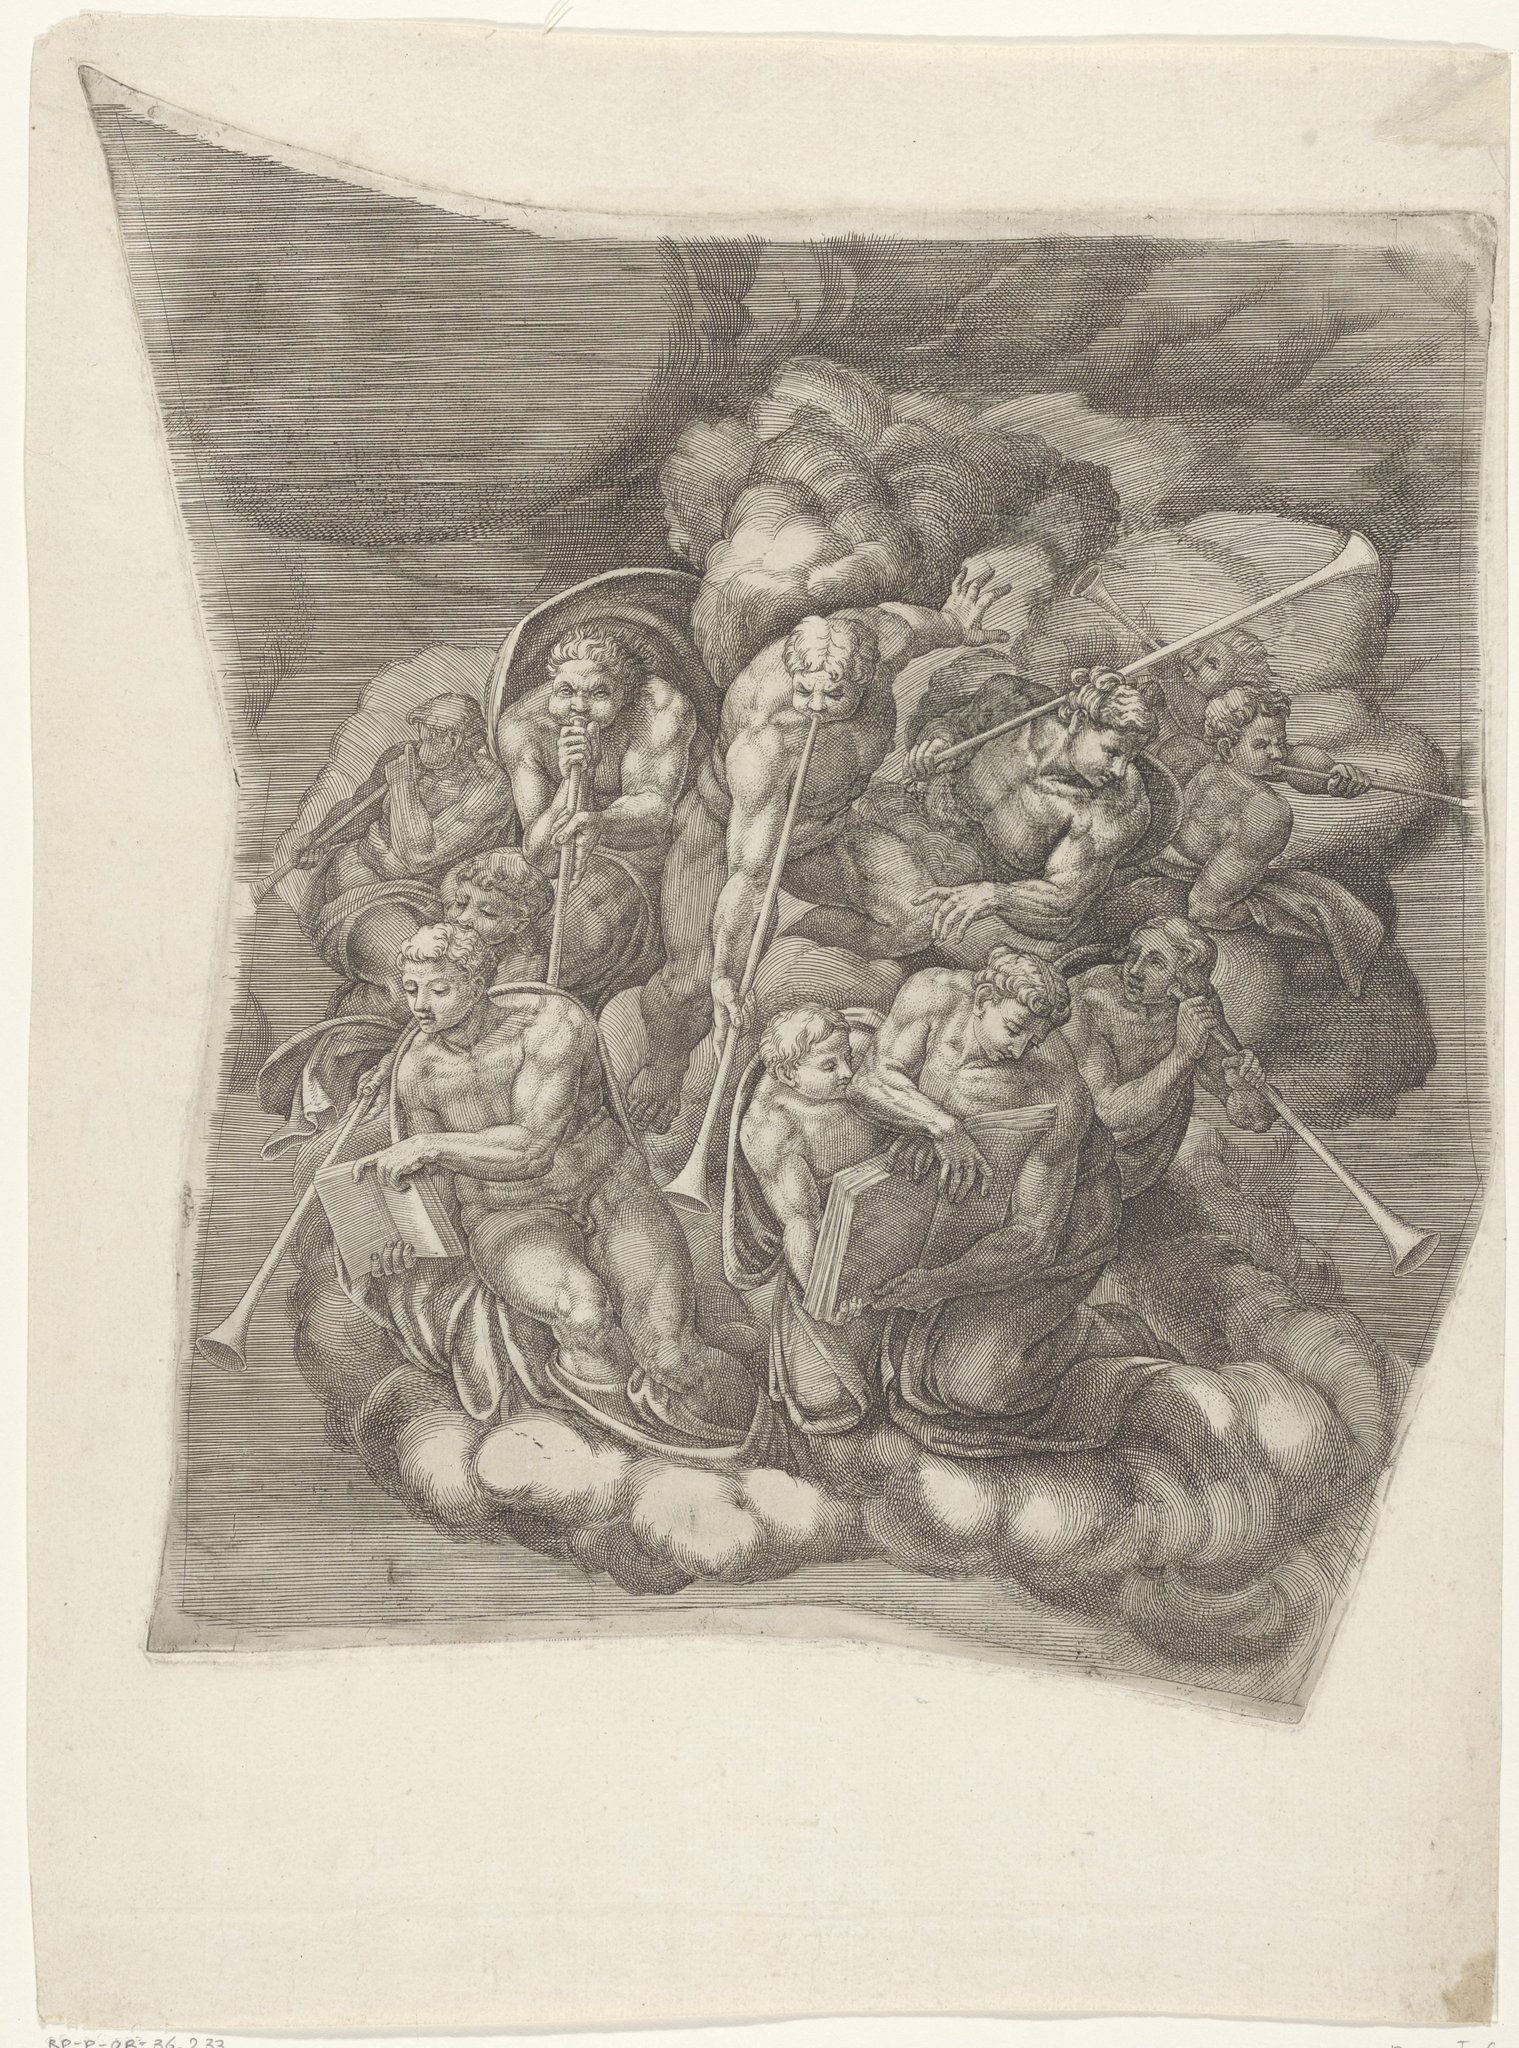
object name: print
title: Het laatste oordeel, blad G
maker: giorgio ghisi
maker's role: print maker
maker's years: 1520-1582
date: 1530-1582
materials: paper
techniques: engraving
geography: italy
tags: last judgement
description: Prent maakt deel uit van een groep van tien prenten die samen één grote voorstelling vormen naar het fresco met het Laatste Oordeel door Michelangelo in de Sixtijnse Kapel in het Vaticaan.